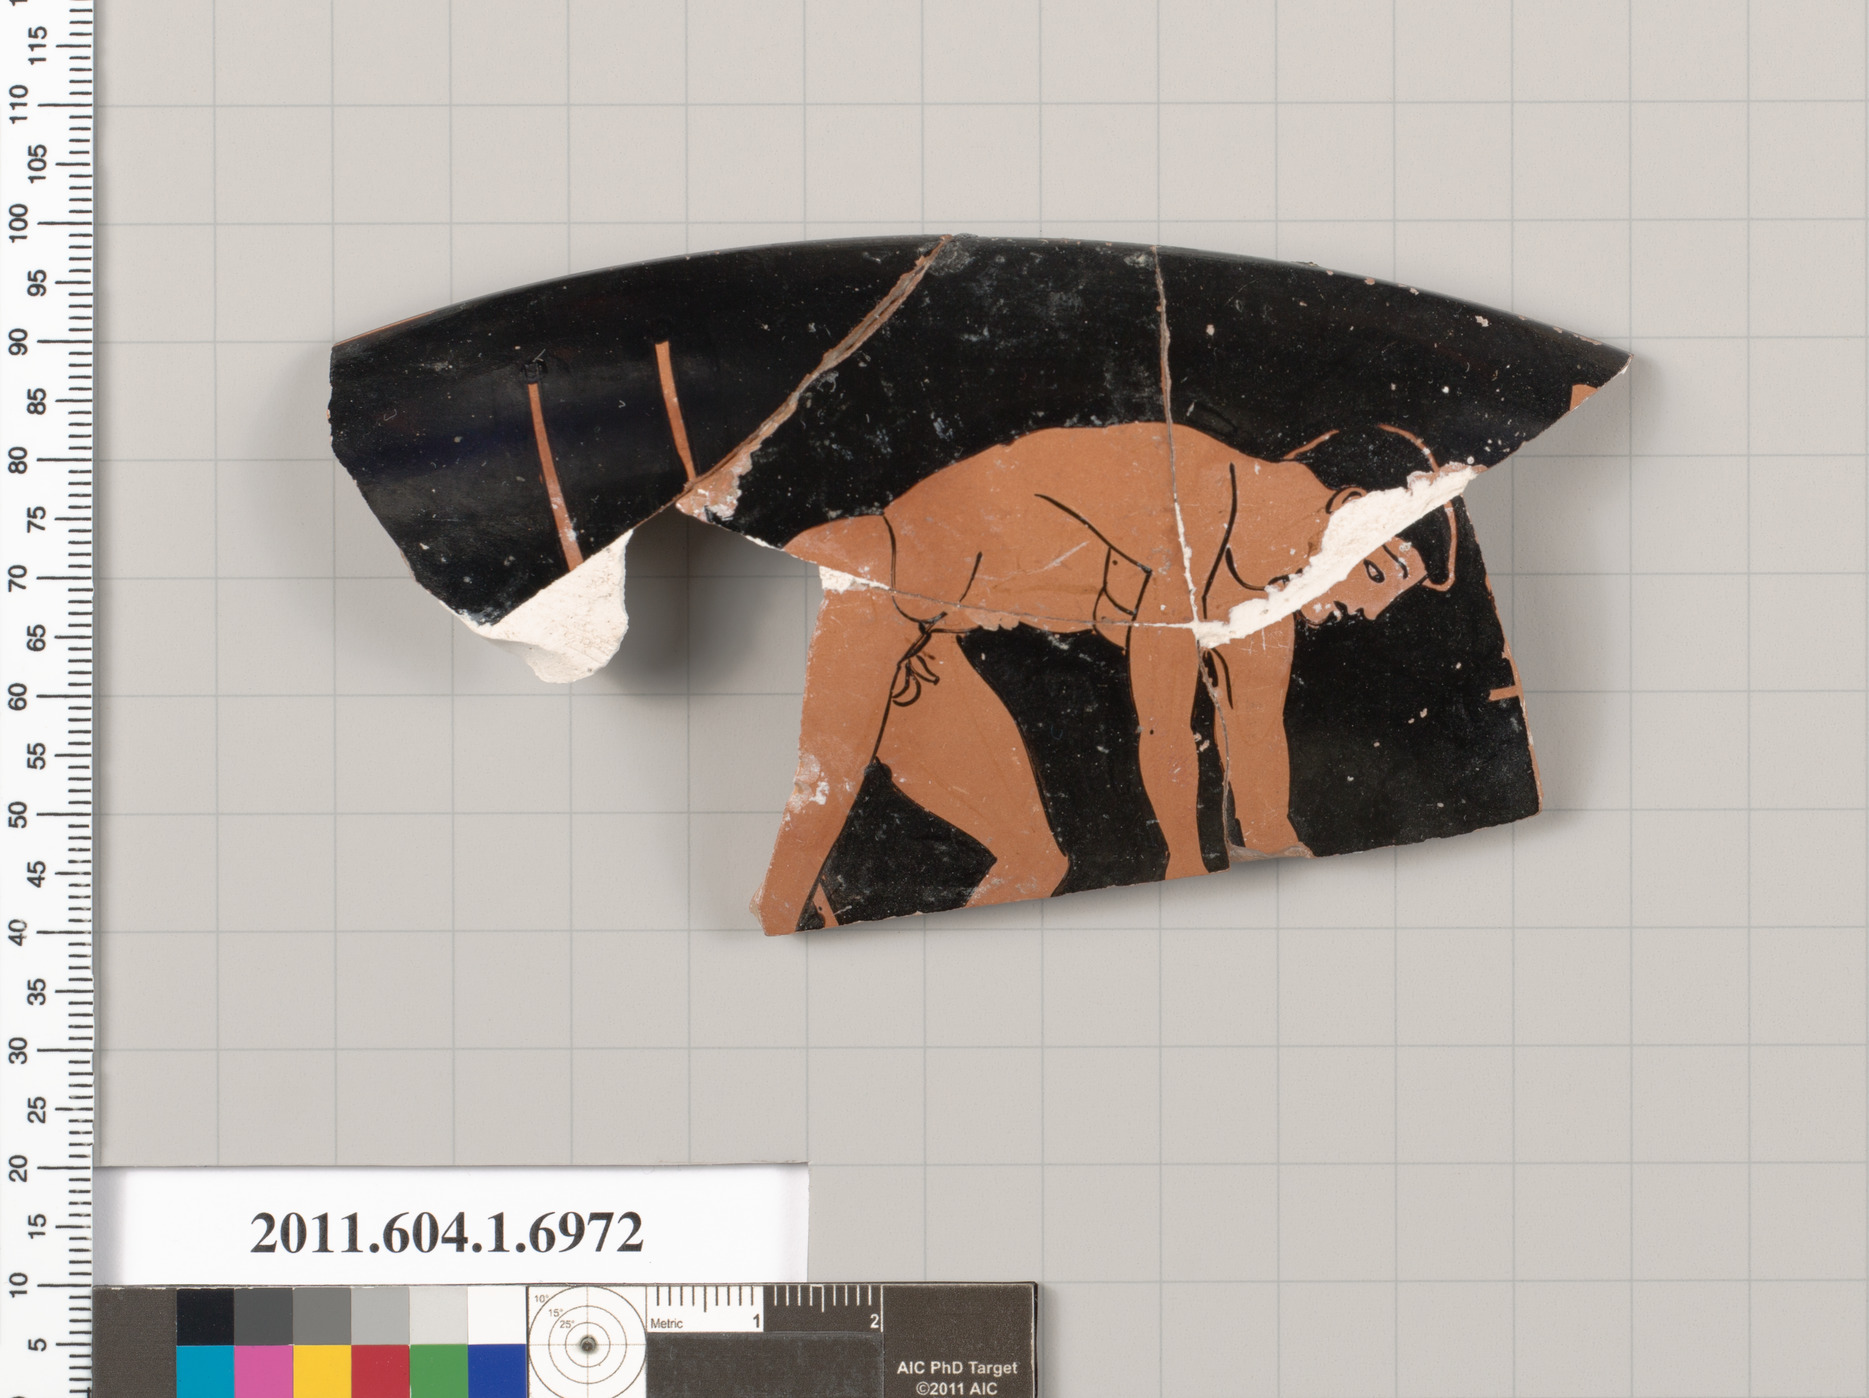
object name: kylix fragment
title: Terracotta rim fragment of a kylix (drinking cup)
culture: greek, attic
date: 490-470 BCE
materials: terracotta